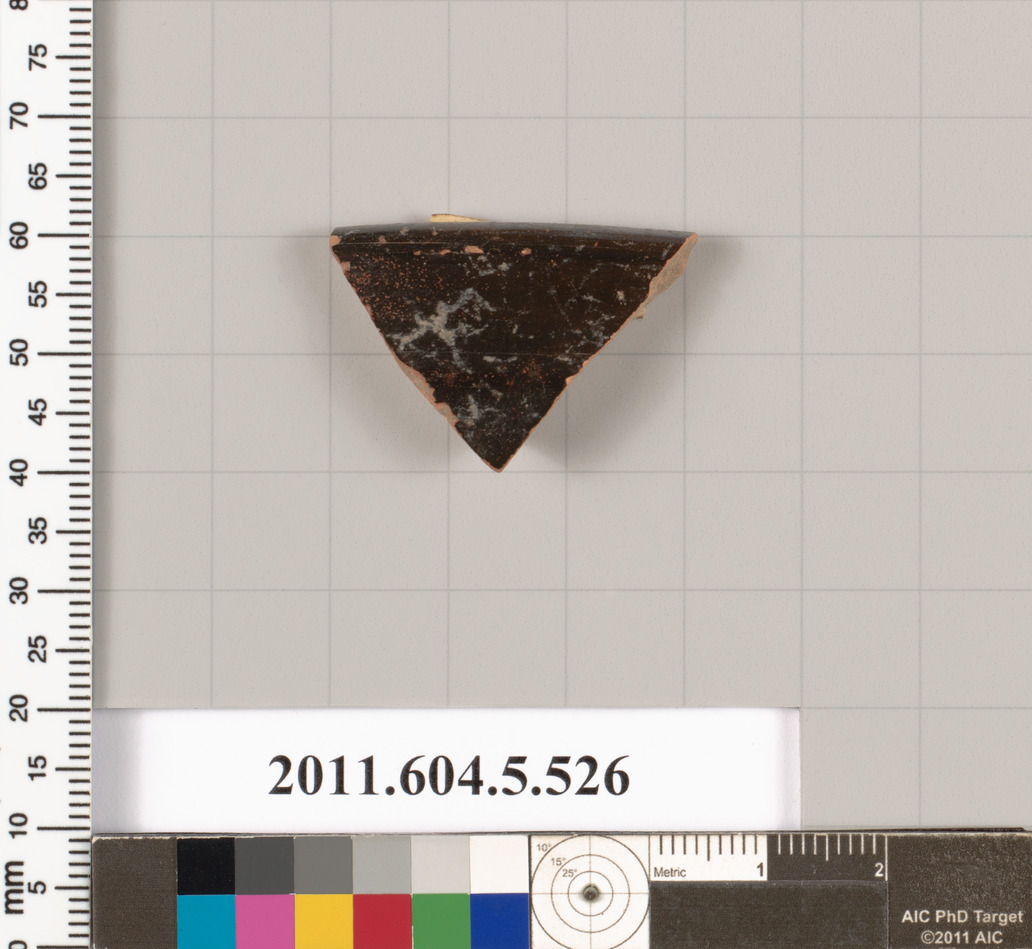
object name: kylix fragment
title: Terracotta rim fragment of a kylix (drinking cup)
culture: greek, attic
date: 600-401 BCE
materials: terracotta